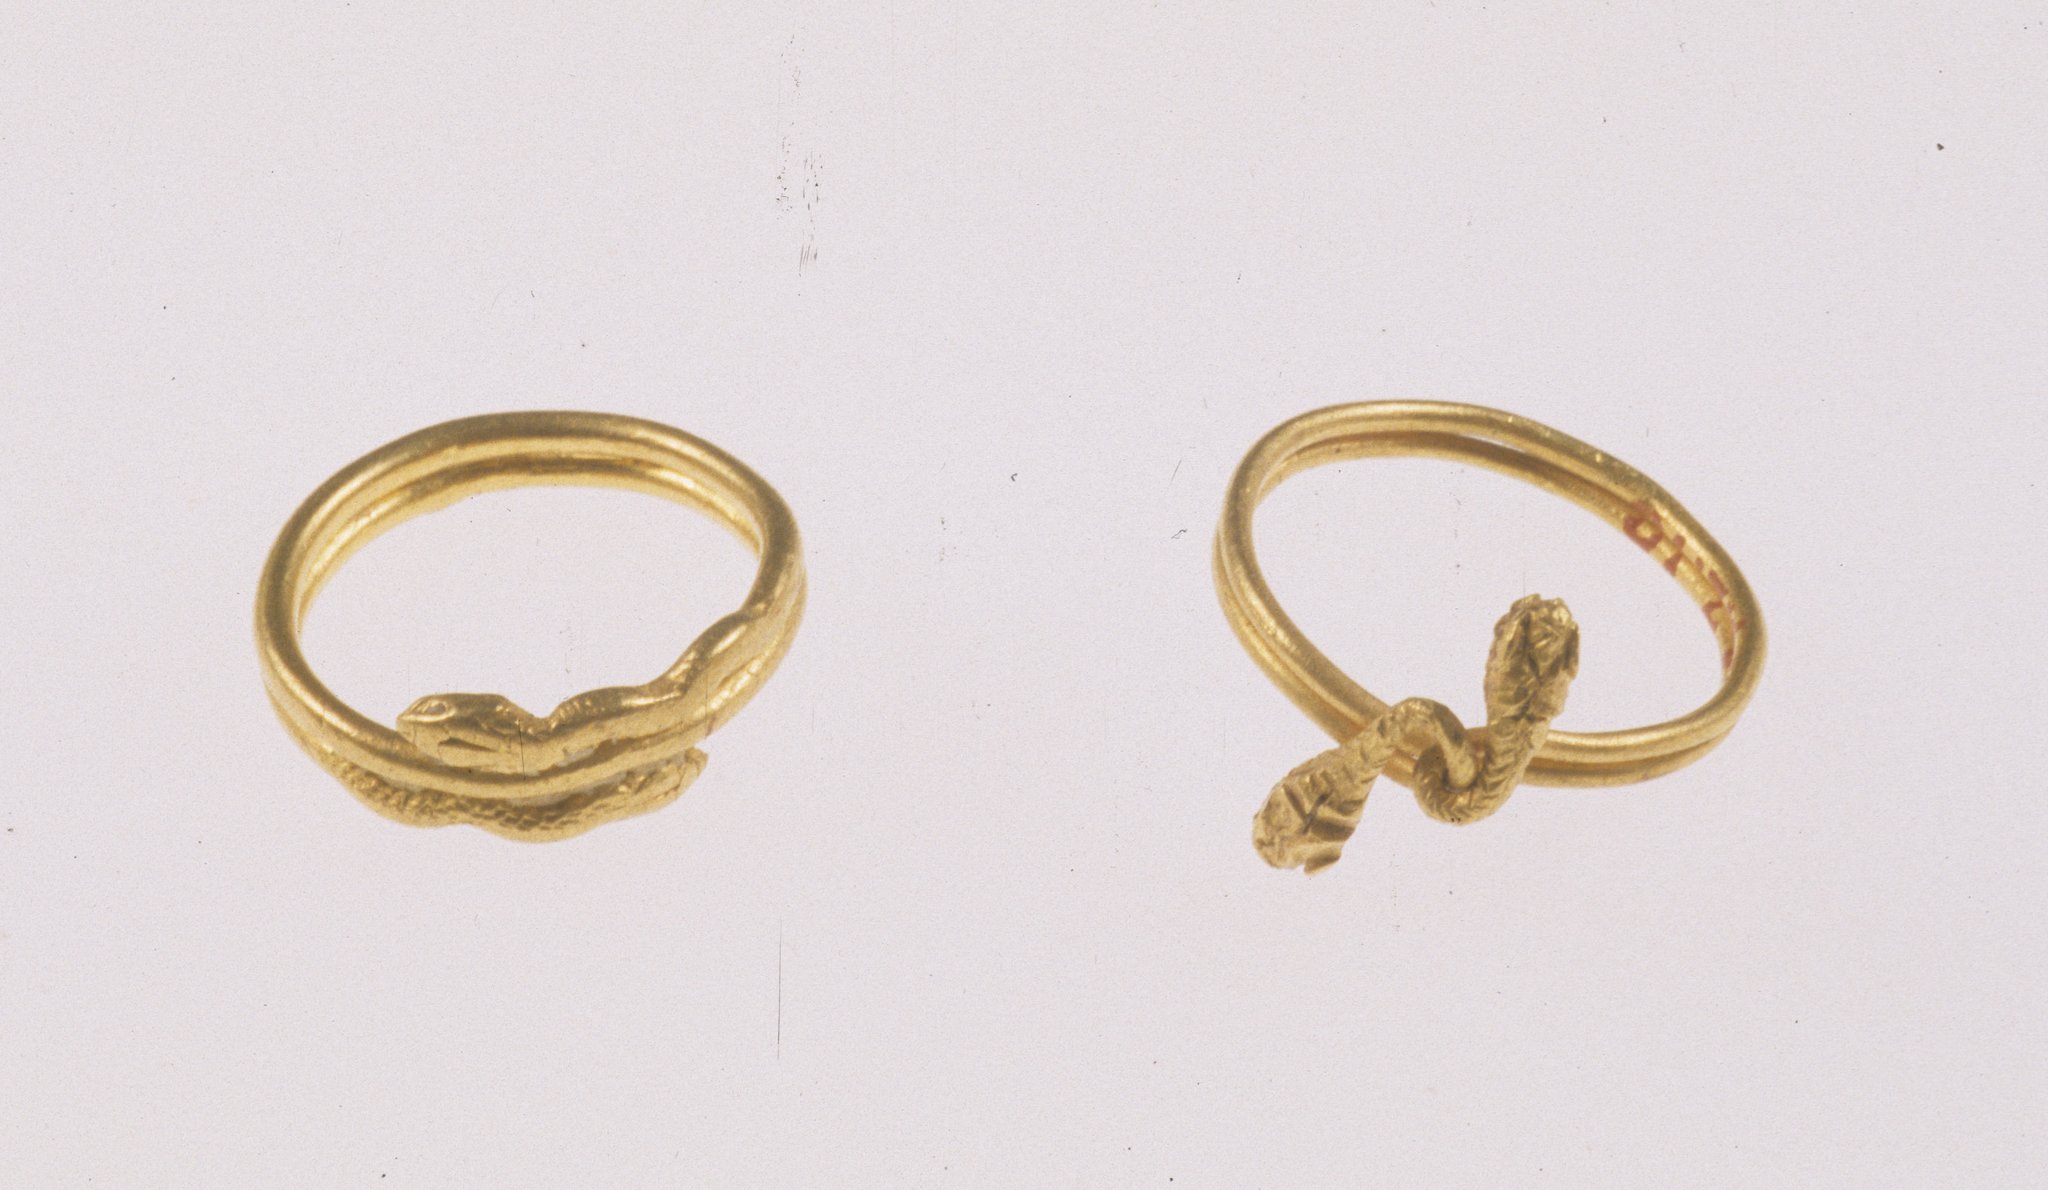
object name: ring, snake terminal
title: Ring with snake's head terminals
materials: gold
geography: egypt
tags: snakes